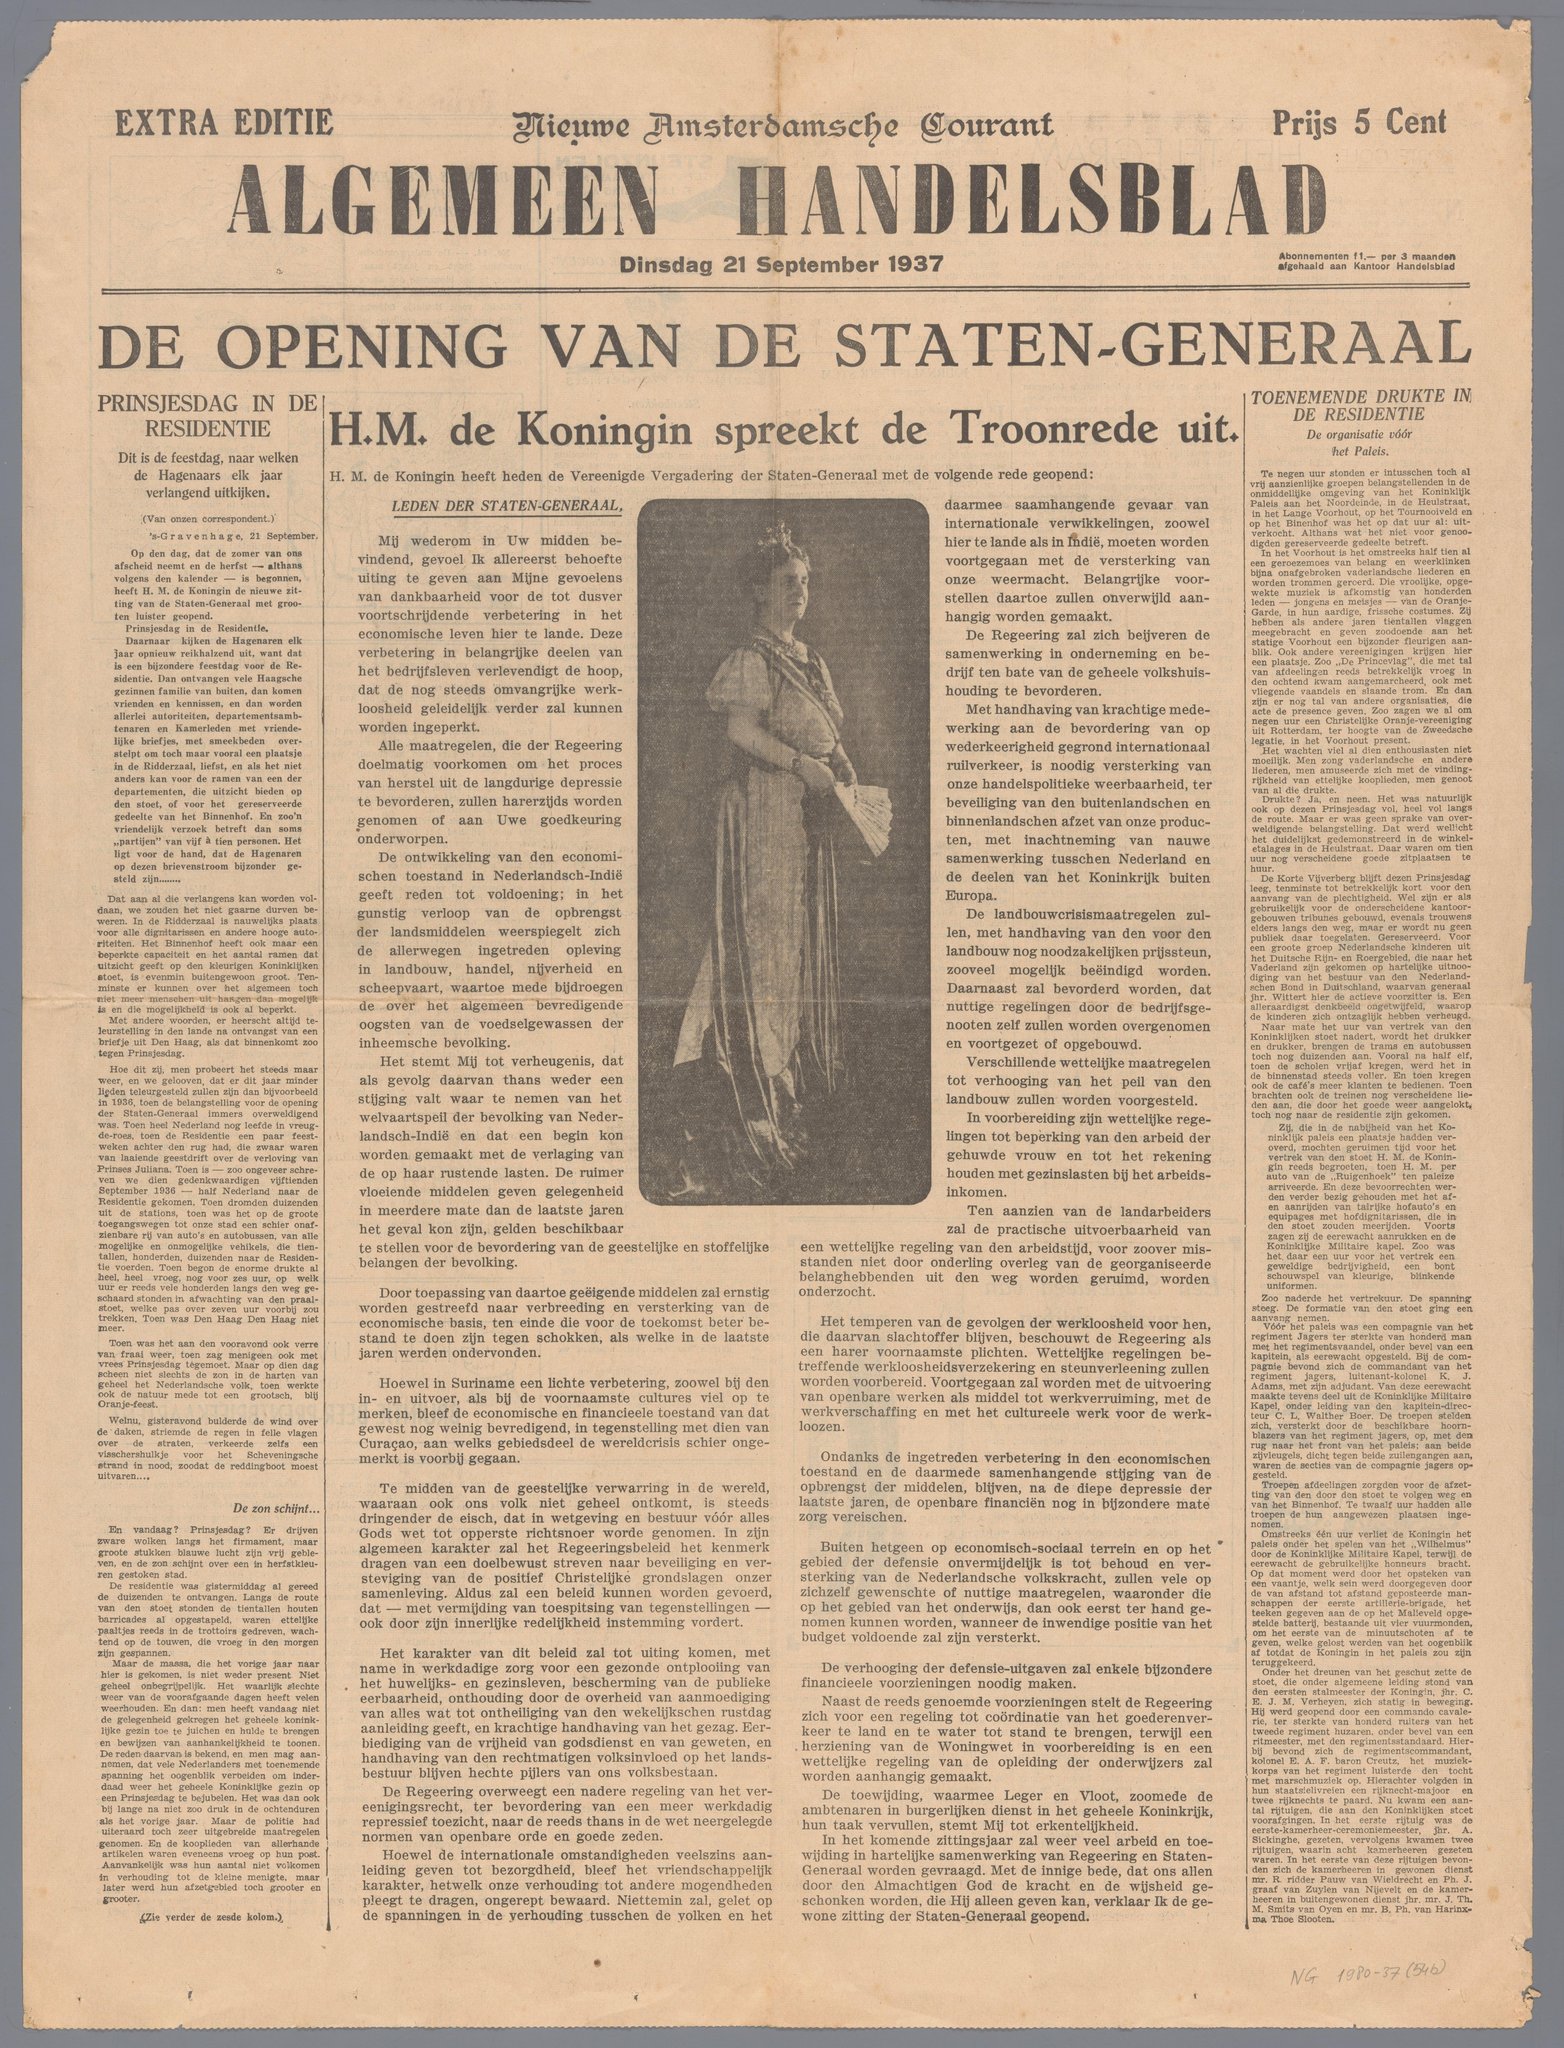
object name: newspaper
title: Algemeen Handelsblad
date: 1937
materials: paper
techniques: printing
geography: amsterdam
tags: the hague, wilhelmina of the netherlands, netherlands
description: Deel van een krant, extra editie 'Algemeen Handelsblad' 1 blad, 2 pp met troonrede en portret Wilhelmina.